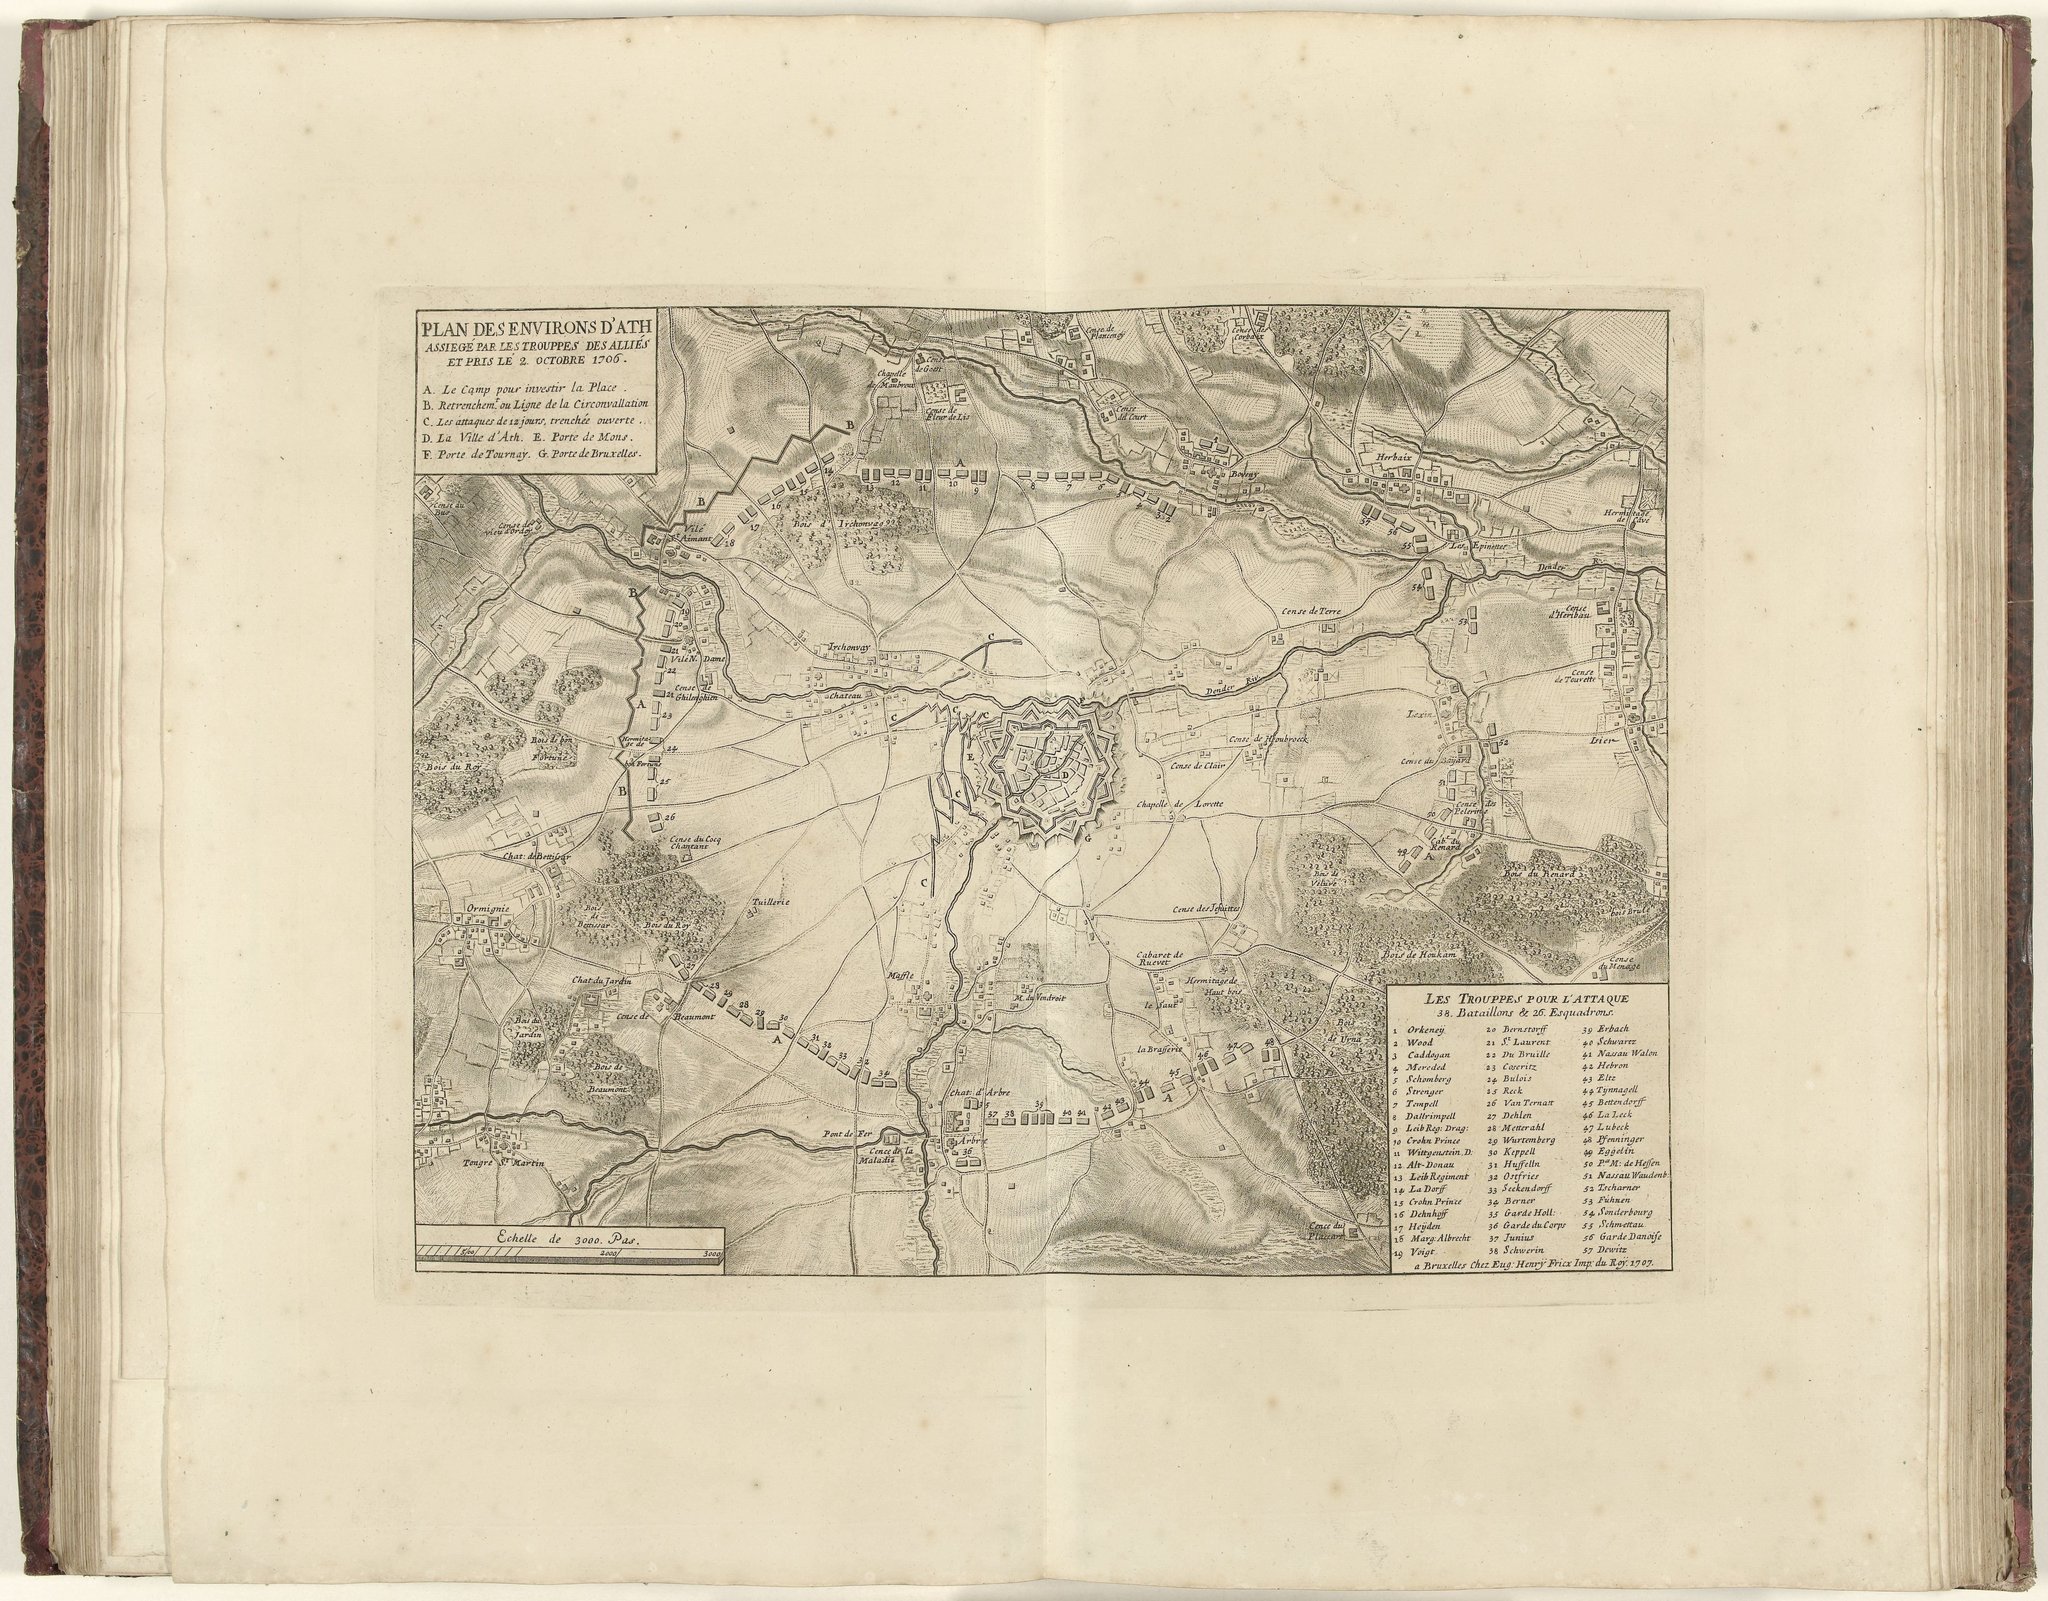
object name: map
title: Plan des environs d'Ath assiegé par les trouppes des alliés et pris le 2. octobre 1706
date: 1707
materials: paper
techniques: engraving, etching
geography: brussels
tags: maps of separate countries or regions, siege, position war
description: Kaart van het beleg van Ath door de Geallieerden, ingenomen op 2 oktober 1706. Rechtsonder een cartouche met een lijst van de Geallieerde regimenten die deel namen aan de belegering. Onderdeel van een gebundelde verzameling van plannen van veldslagen en steden vermaard in de Spaanse Successieoorlog.